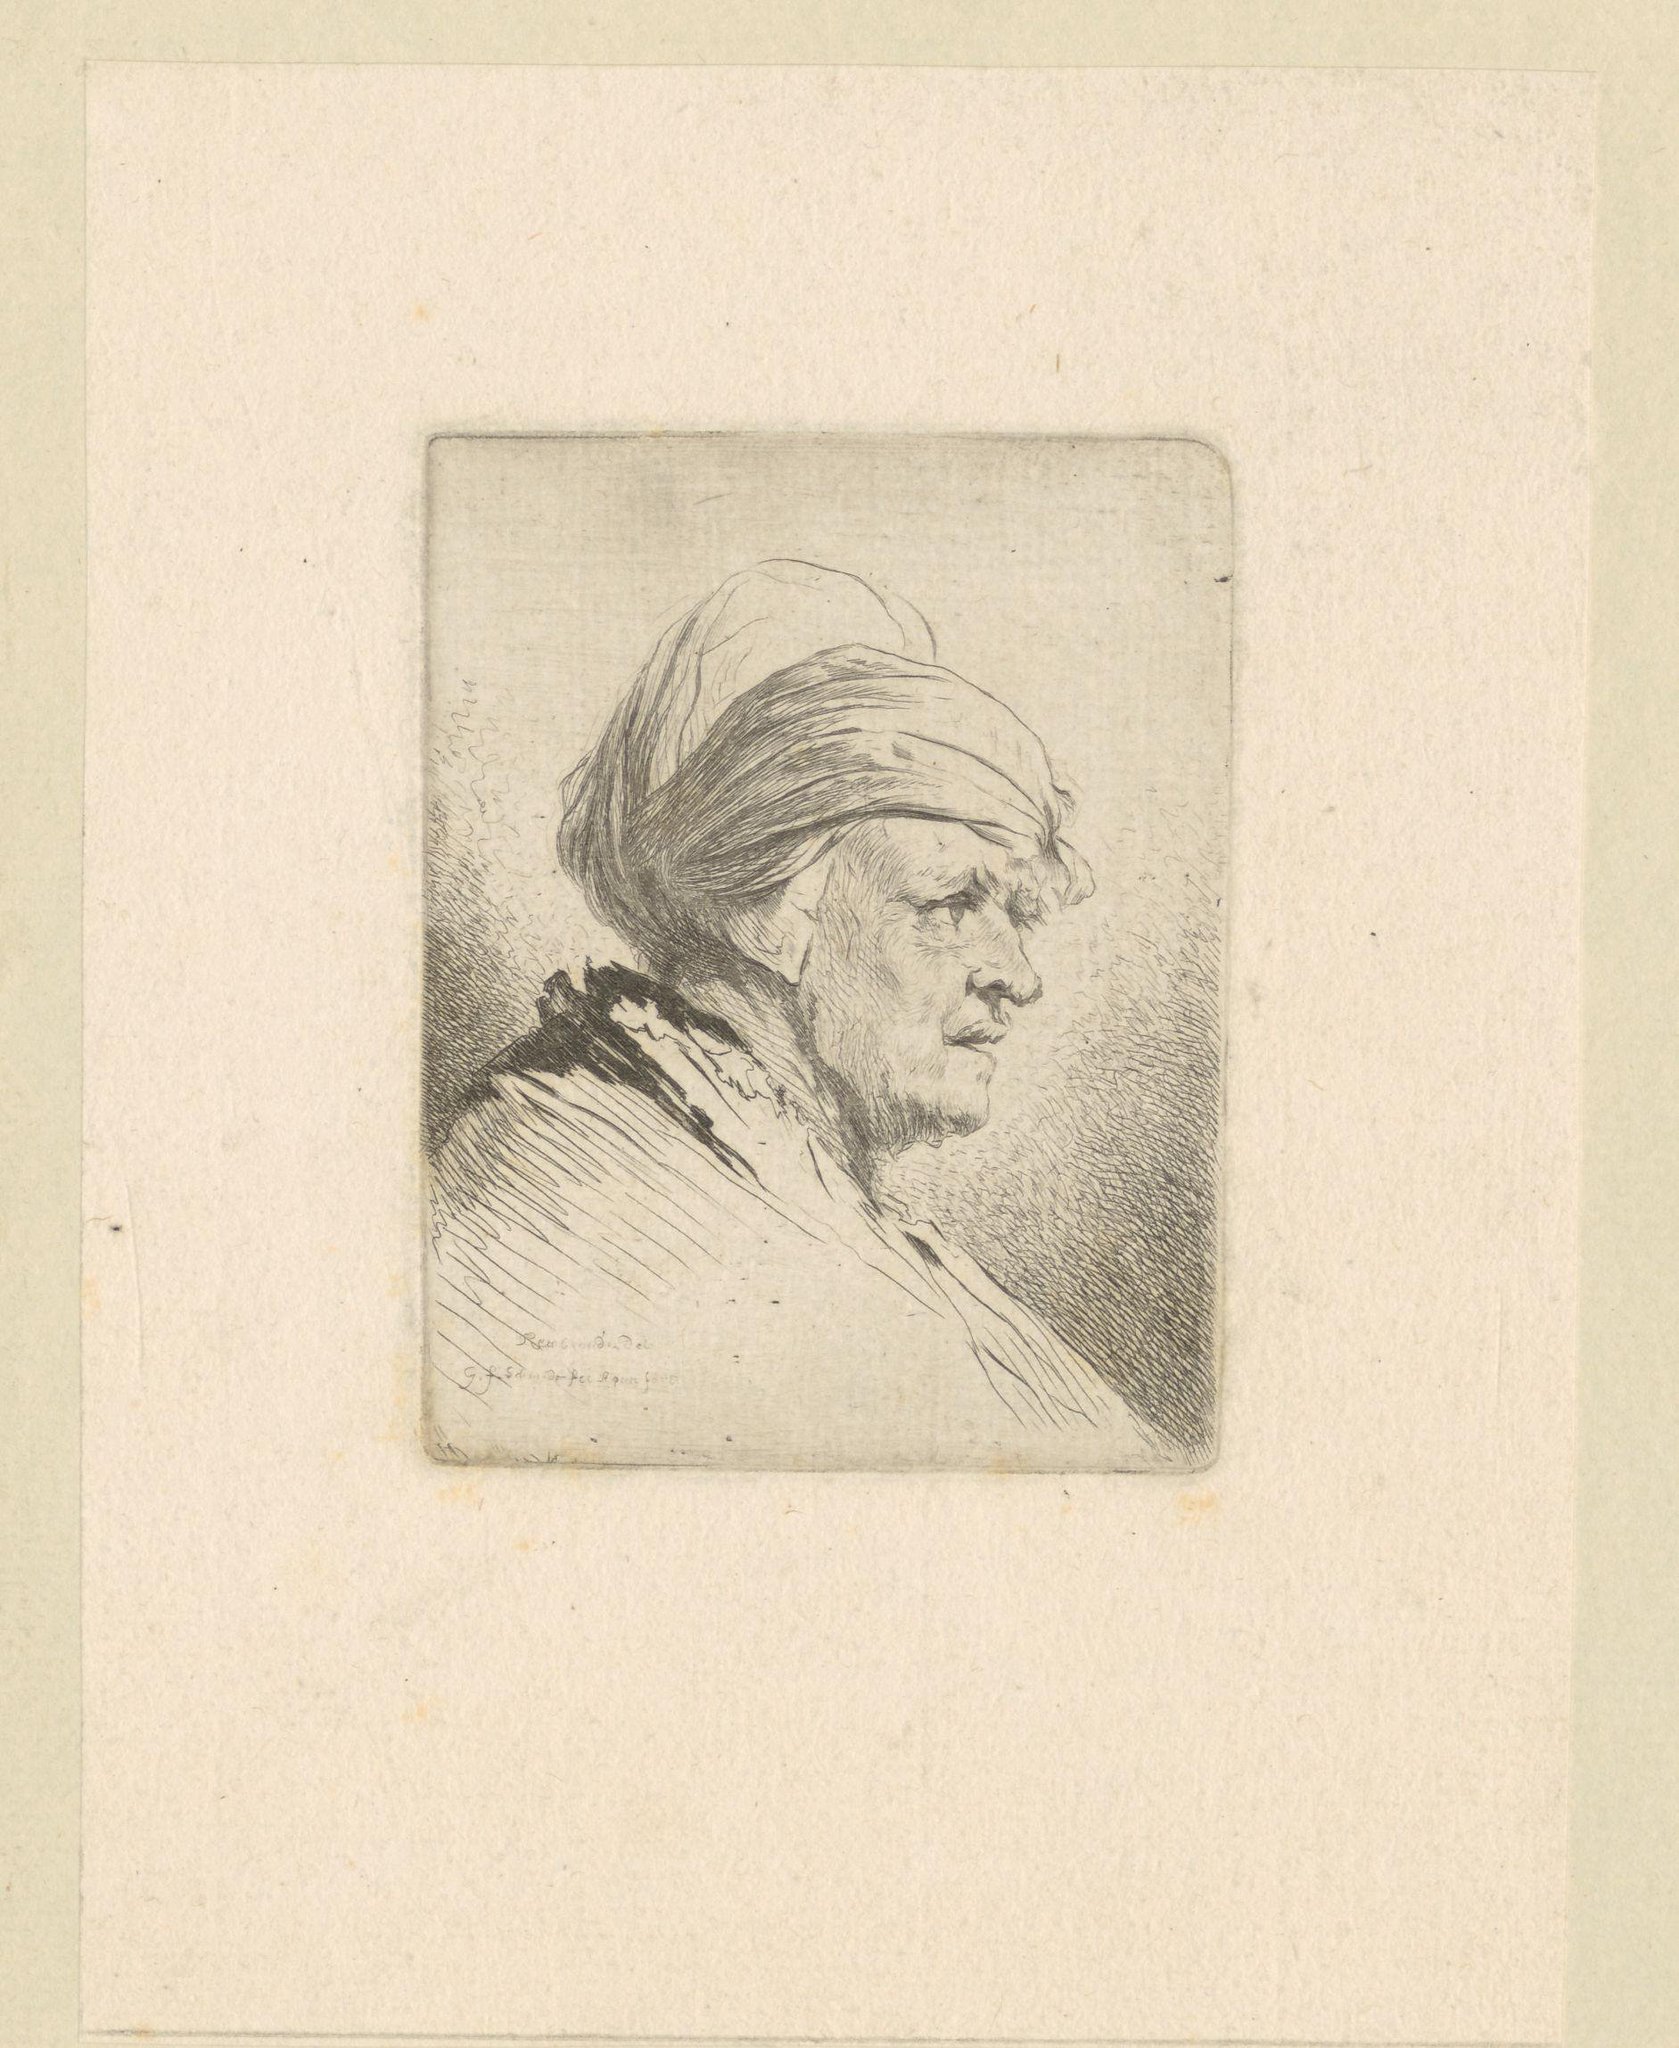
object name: print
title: Oude vrouw met doek om hoofd gebonden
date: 1722-1775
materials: paper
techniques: etching, intaglio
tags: old woman